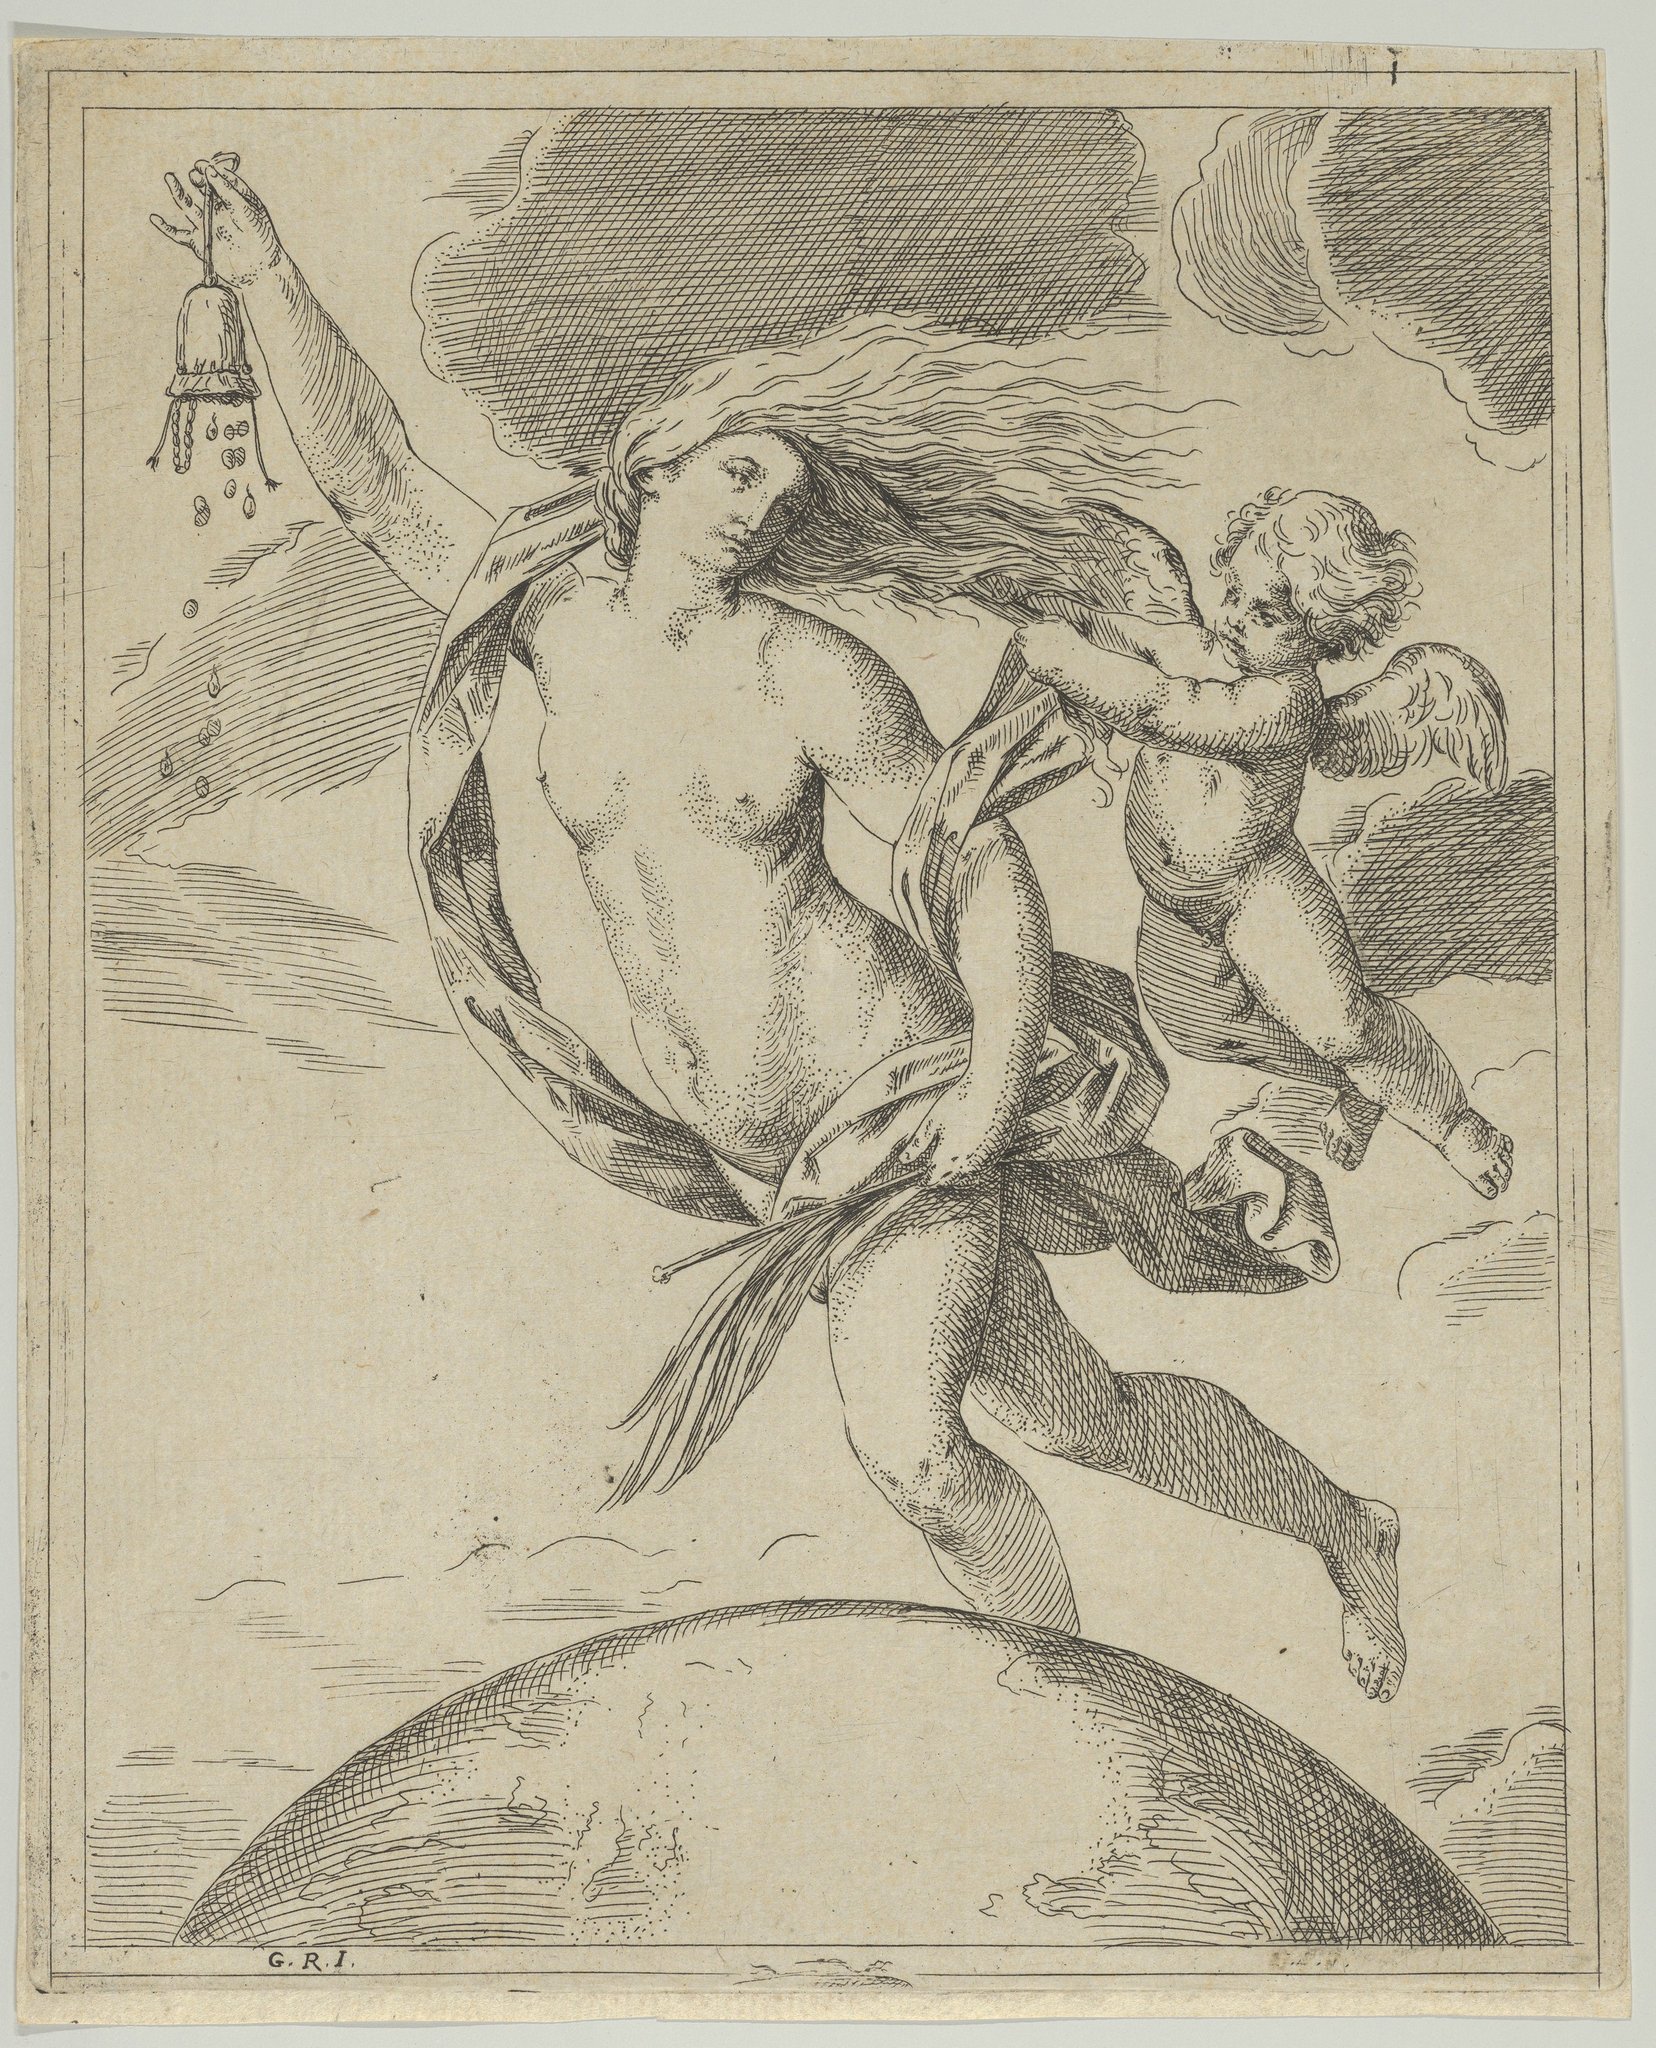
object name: print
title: Fortune flying above the globe, partly naked, emptying a purse in her raised right hand and holding a staff in her left, a winged putto pulling her forelock, after Reni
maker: girolamo scarsello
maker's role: artist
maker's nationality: italian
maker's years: 1624-1678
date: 1660-1680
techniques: etching